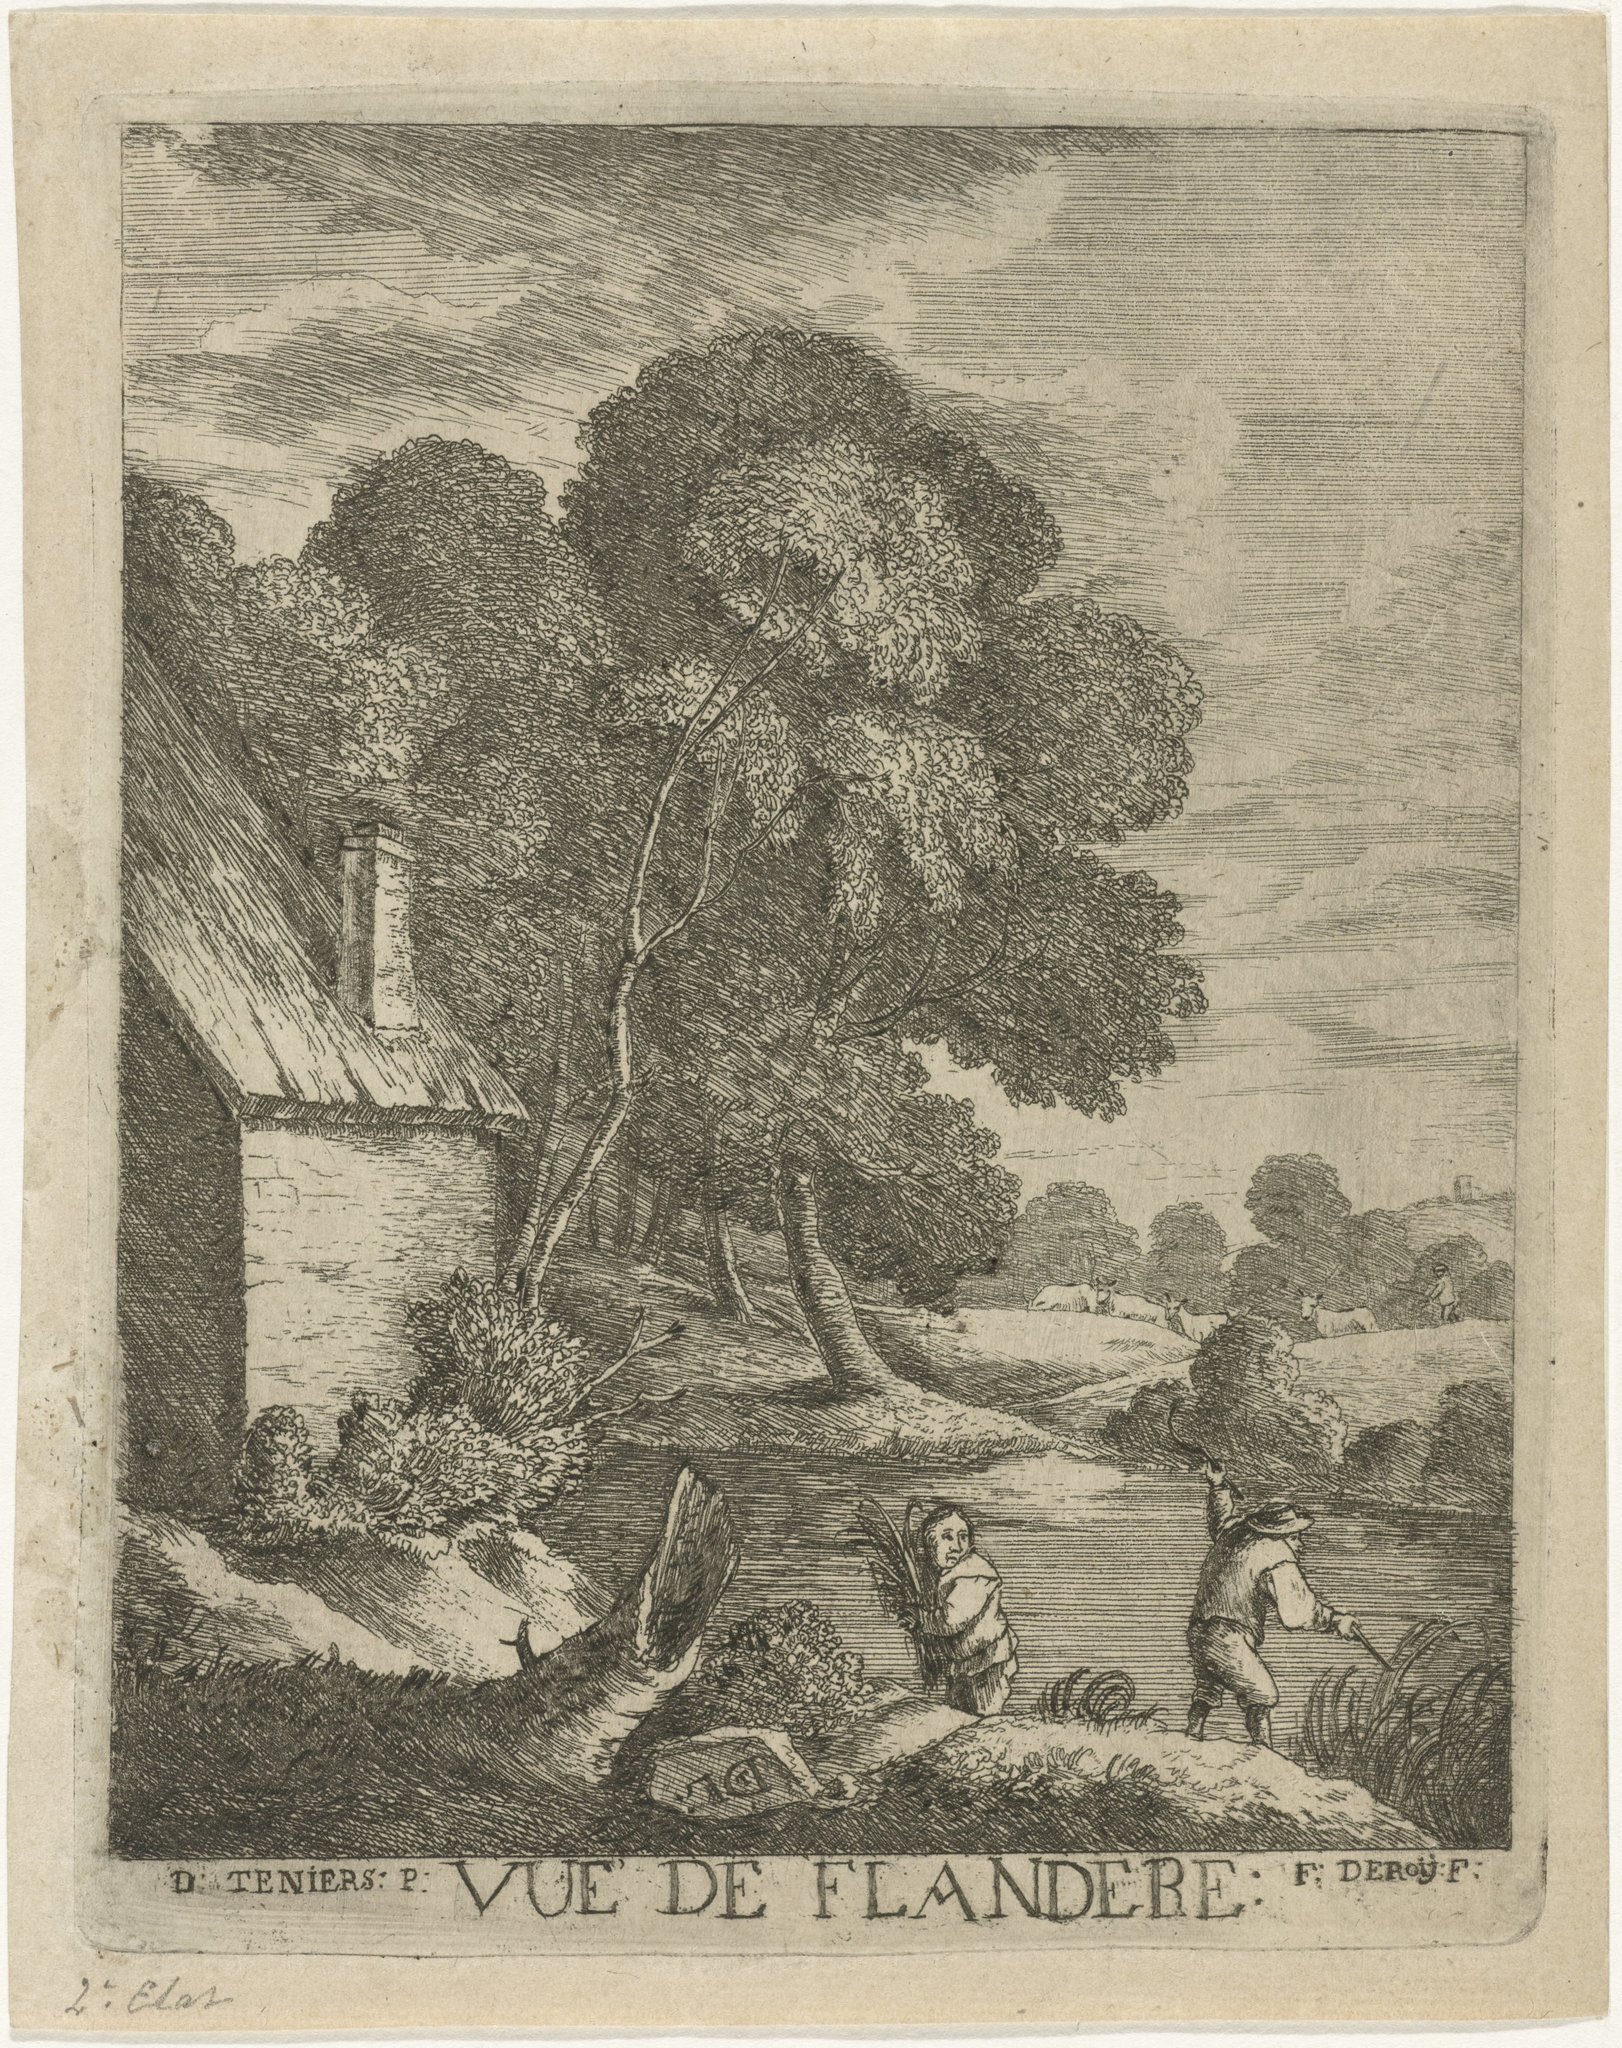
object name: print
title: Vue de Flandere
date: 1758-1762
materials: paper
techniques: etching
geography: southern netherlands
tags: low hill country, cow, herding, herdsman, herdswoman, shepherd, shepherdess, cowherd, etc., pool, puddle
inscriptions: collector's mark: Lugt 514, collector's mark: Lugt 2228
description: Gezicht op een Vlaams landschap, met op de voorgrond twee mannen bij een vijver. Links een huis en op de achtergrond een herder met zijn kudde.